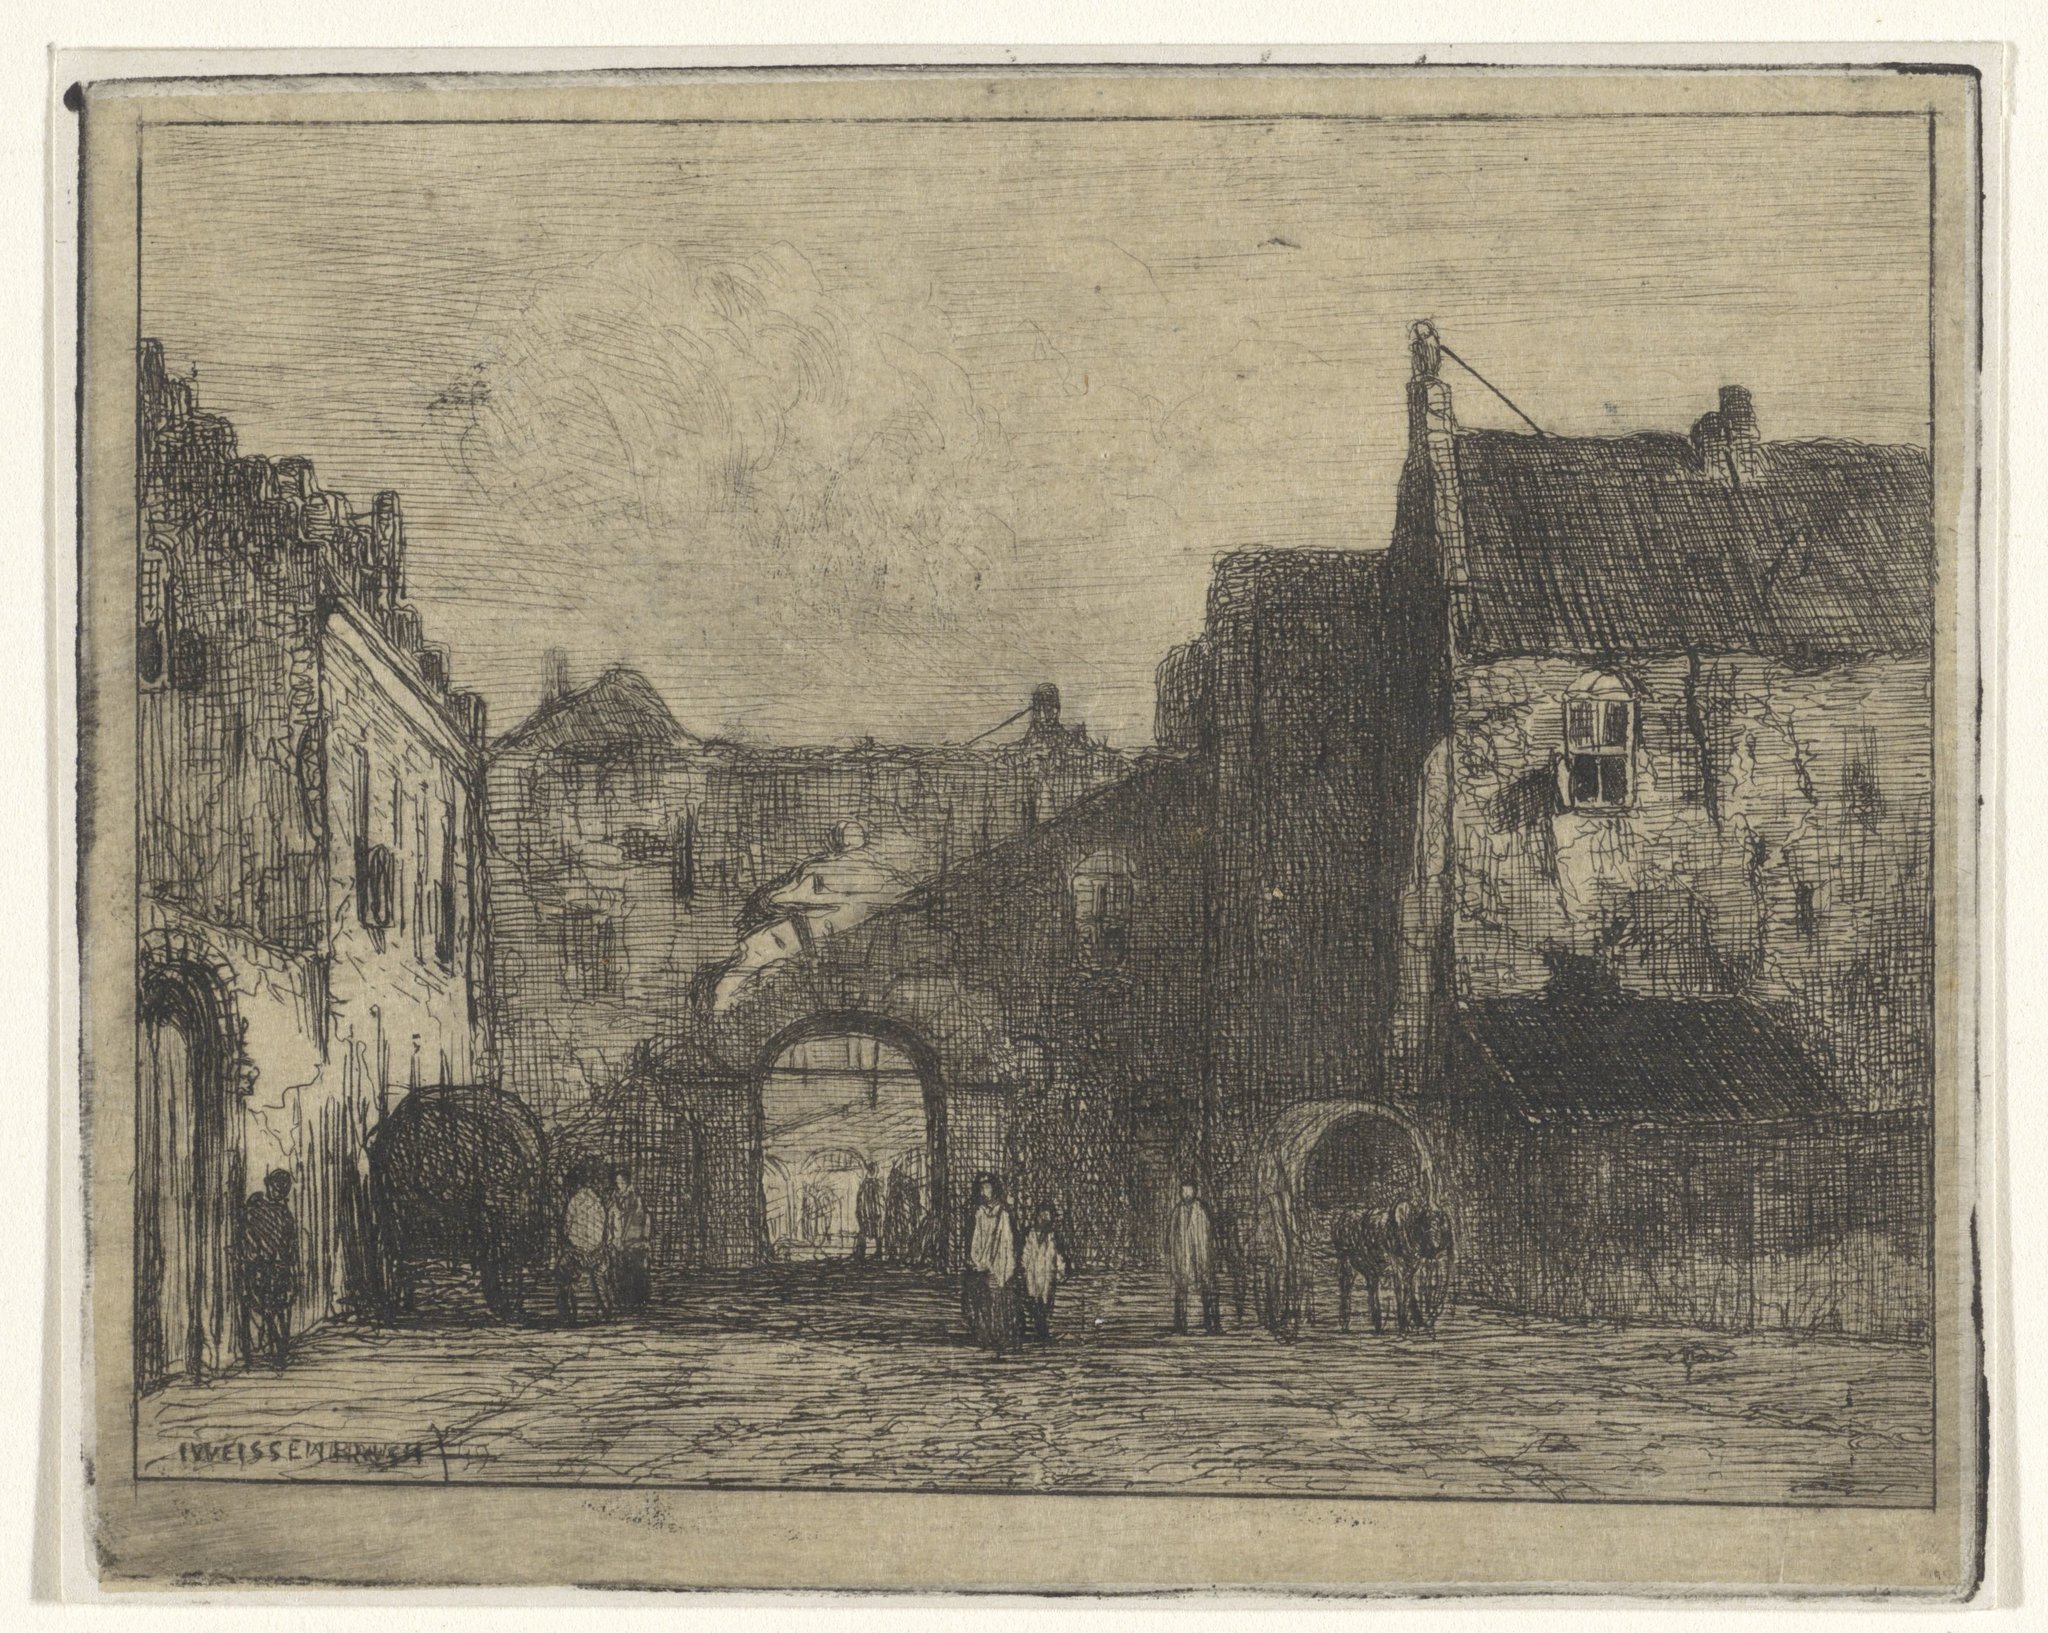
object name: print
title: Gezicht op het Binnenhof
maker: jan weissenbruch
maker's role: painter, print maker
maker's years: 1822-1880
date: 1849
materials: paper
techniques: etching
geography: the hague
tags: city-view, and landscape with man-made constructions, gate, entrance, horse, passenger carriage, civic architecture; edifices; dwellings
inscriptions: collector's mark: Lugt 2228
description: Op het Binnenhof te Den Haag staan enkele figuren bij twee koetsen met paarden. In de verte ligt de Mauritspoort gezien door de Middenpoort met rechts een gedeelte van de Ridderzaal.